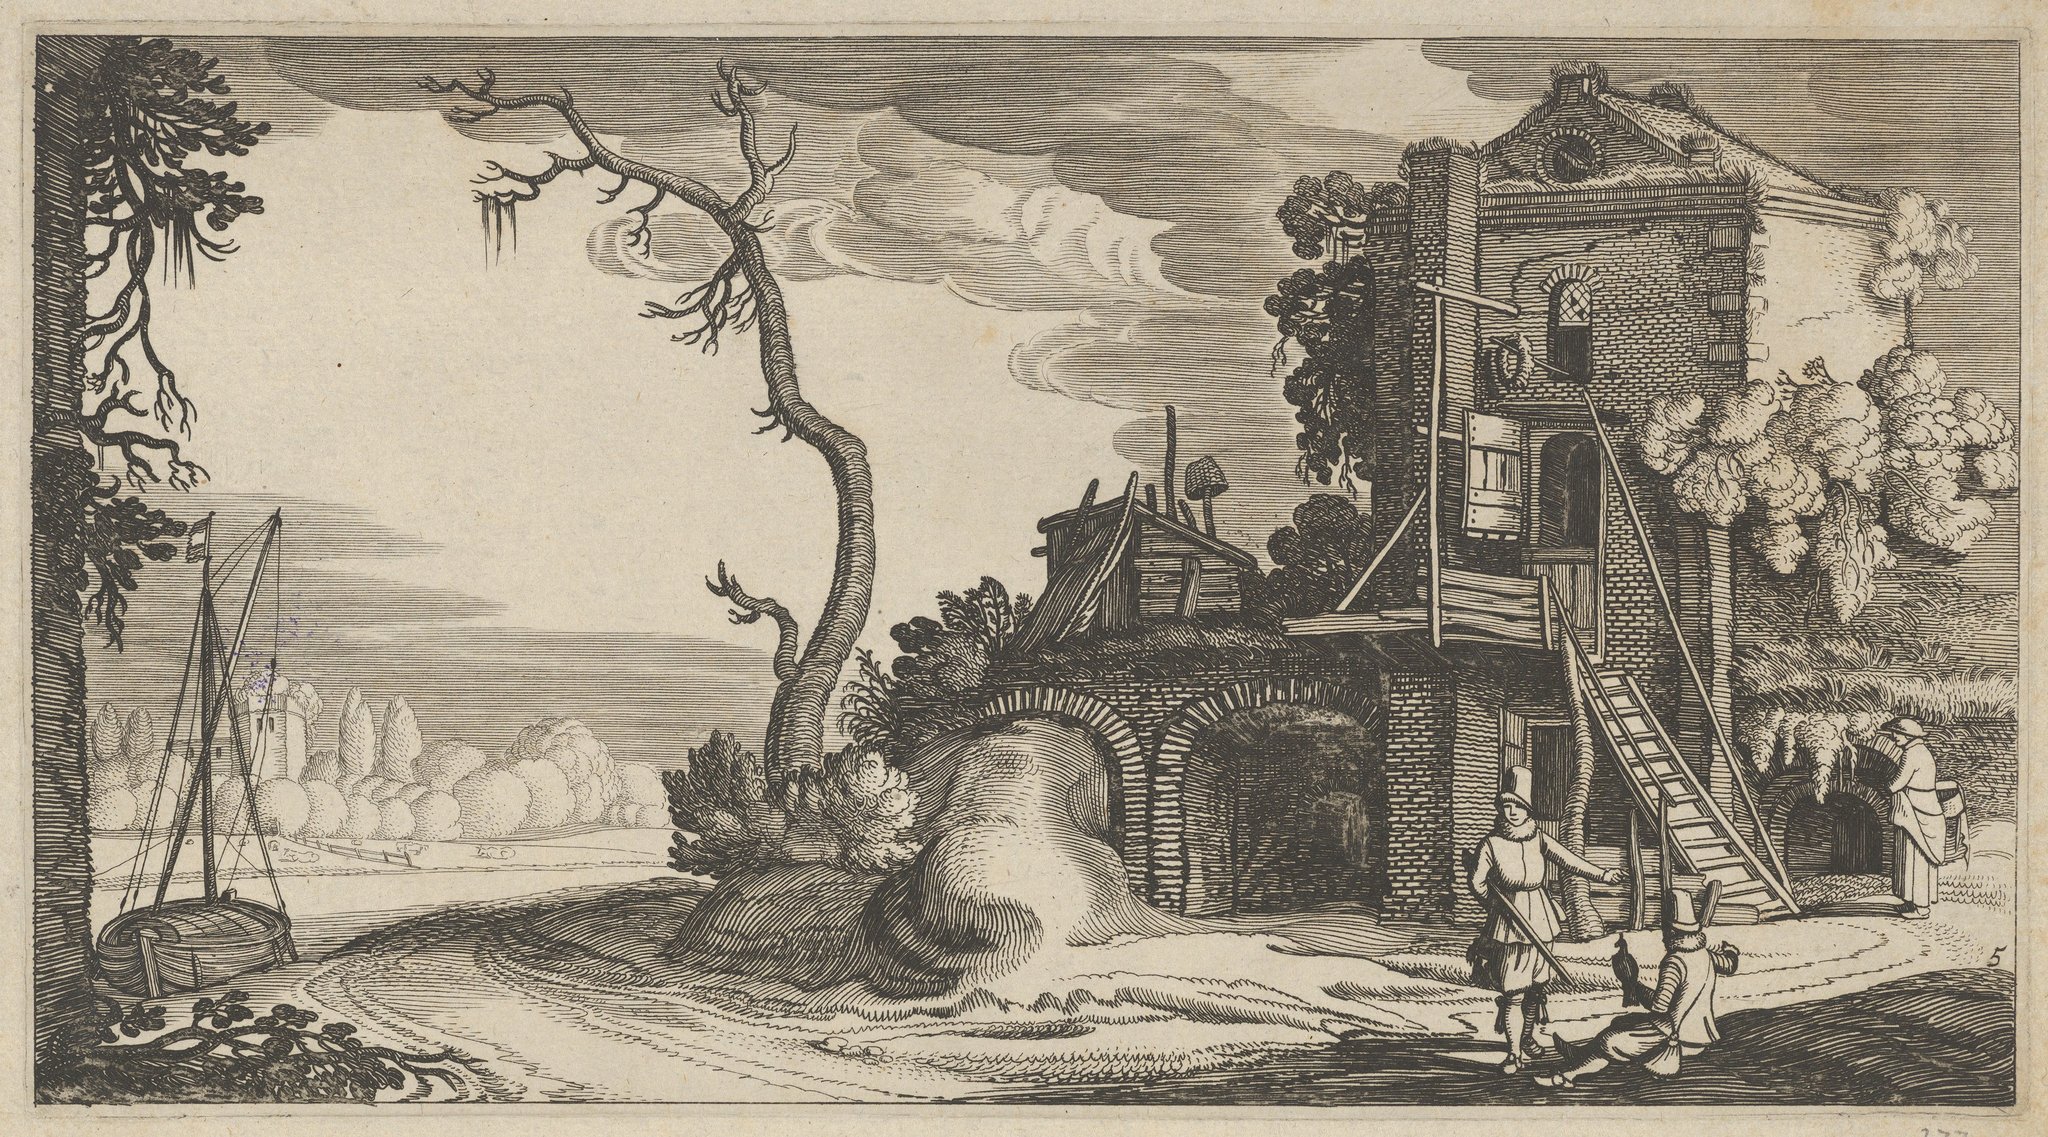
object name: print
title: Square Tower Used as Inn near a River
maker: jan van de velde ii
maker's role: artist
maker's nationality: dutch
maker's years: 1593-1641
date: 1641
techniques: engraving, etching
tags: inns,men,women,rivers,boats